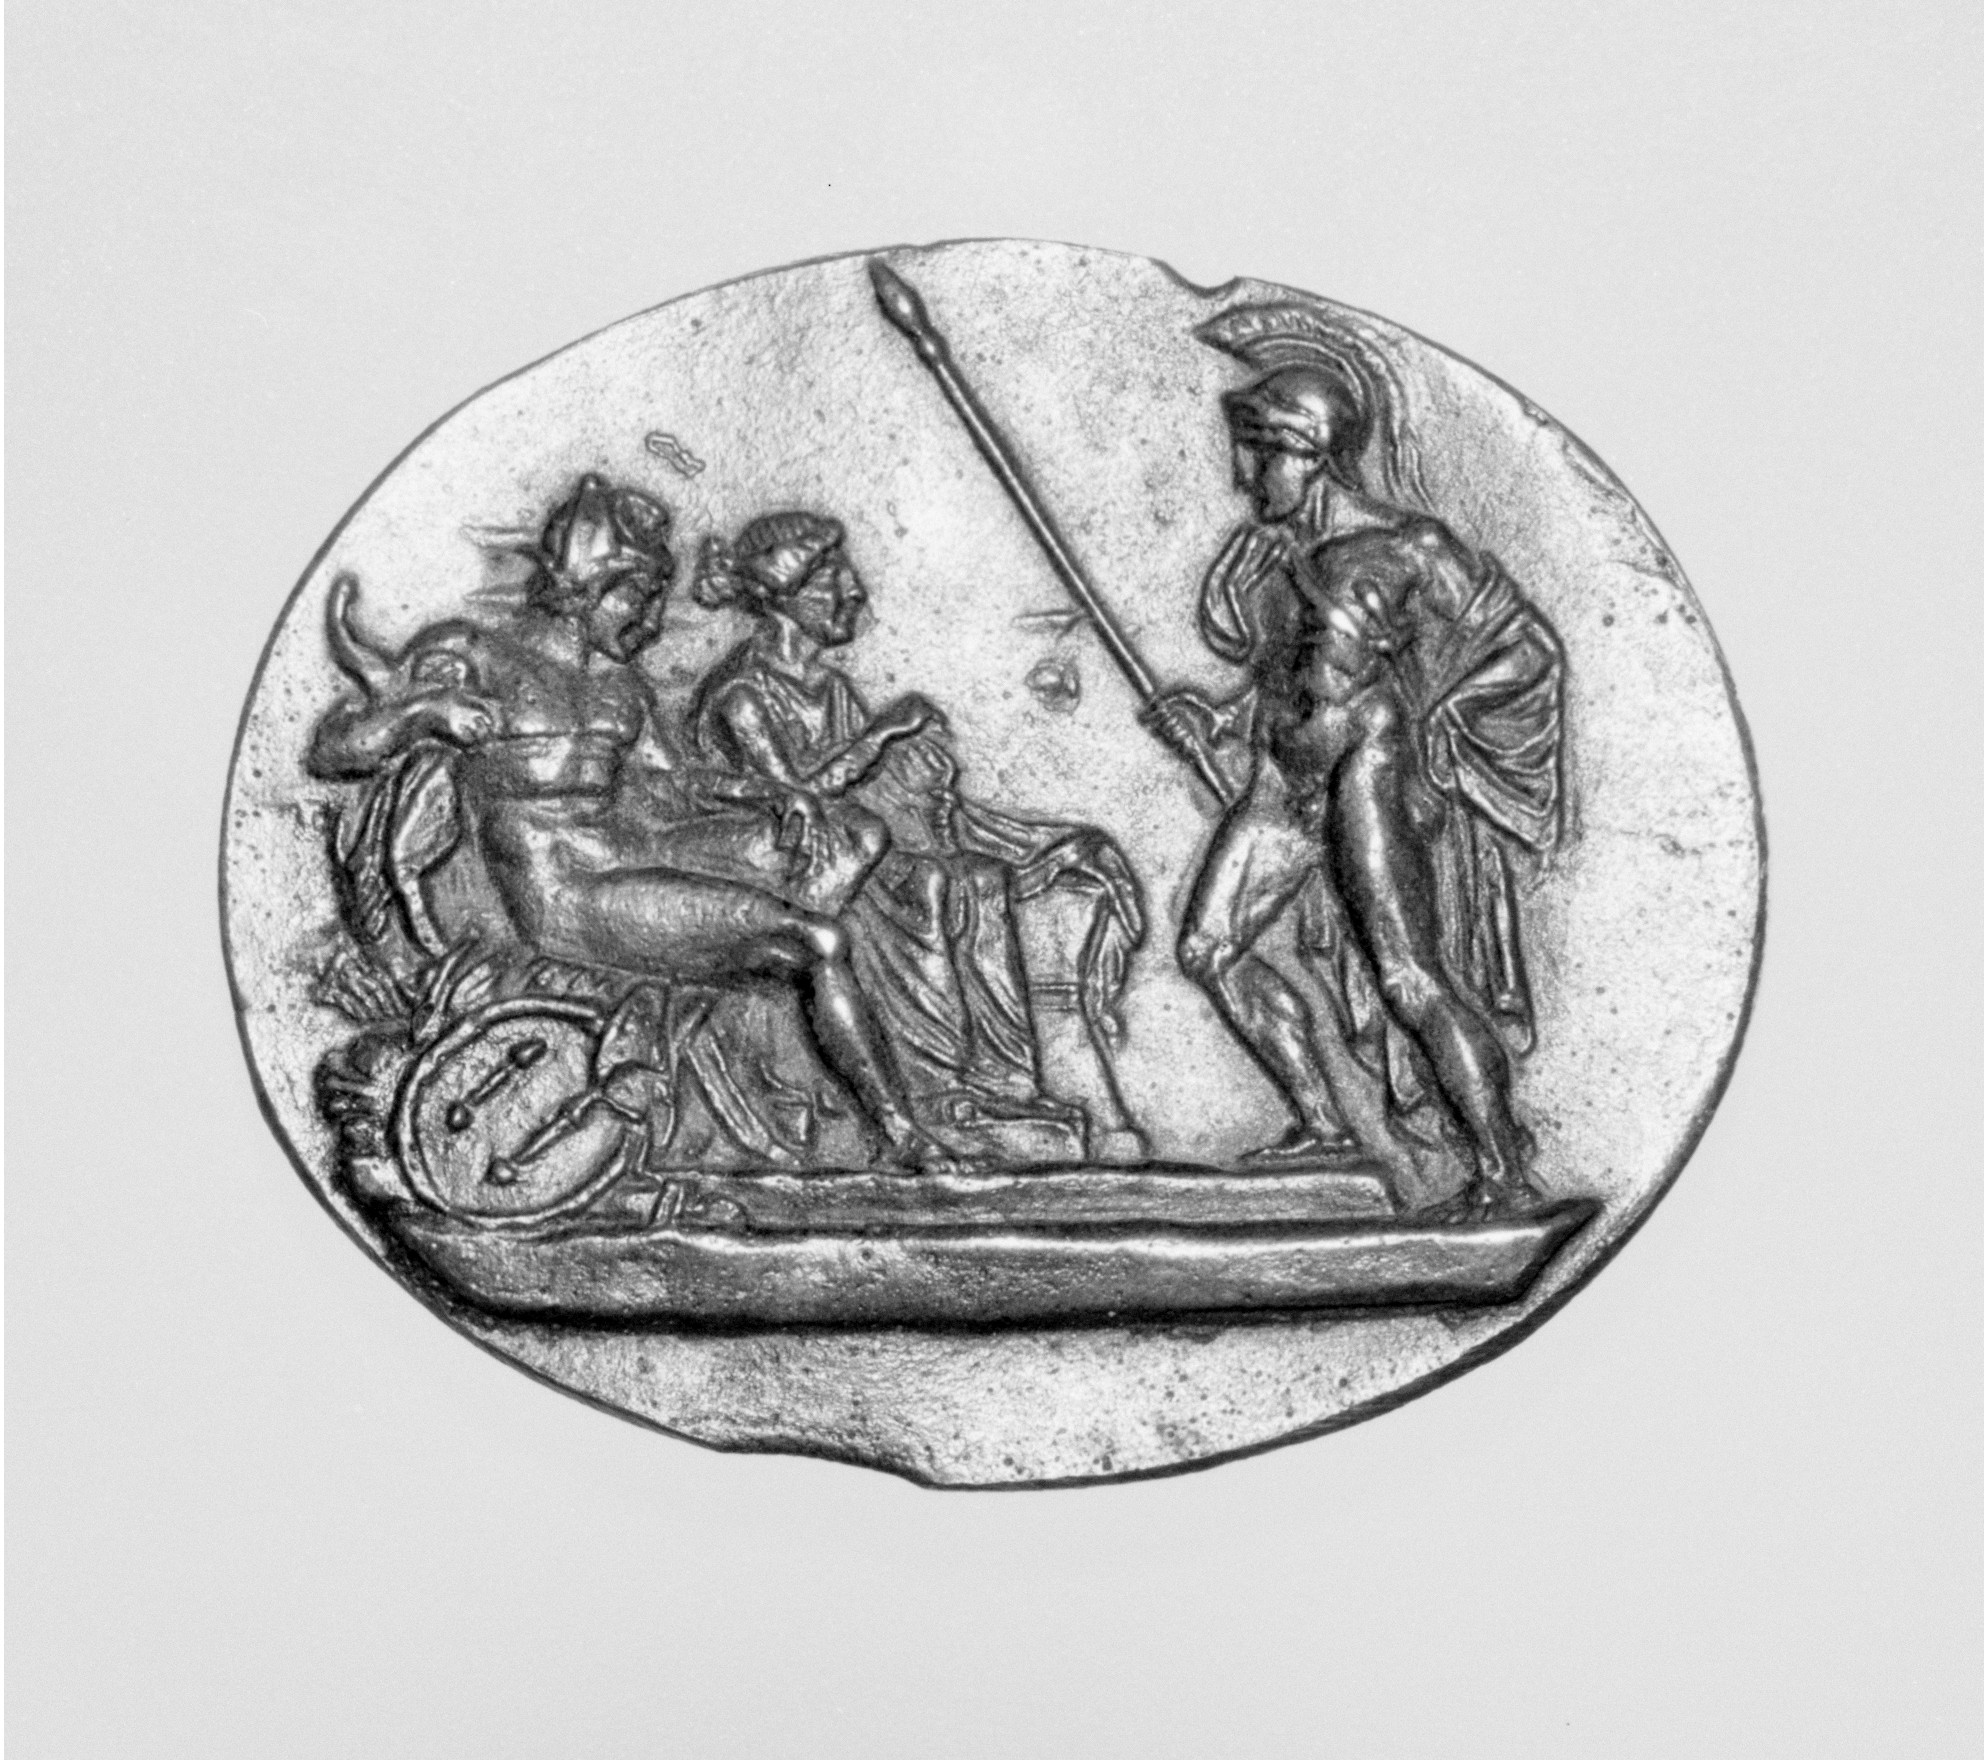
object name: plaquette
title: Warrior standing before a seated couple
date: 1701-1800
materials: bronze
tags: soldiers,spears,couples